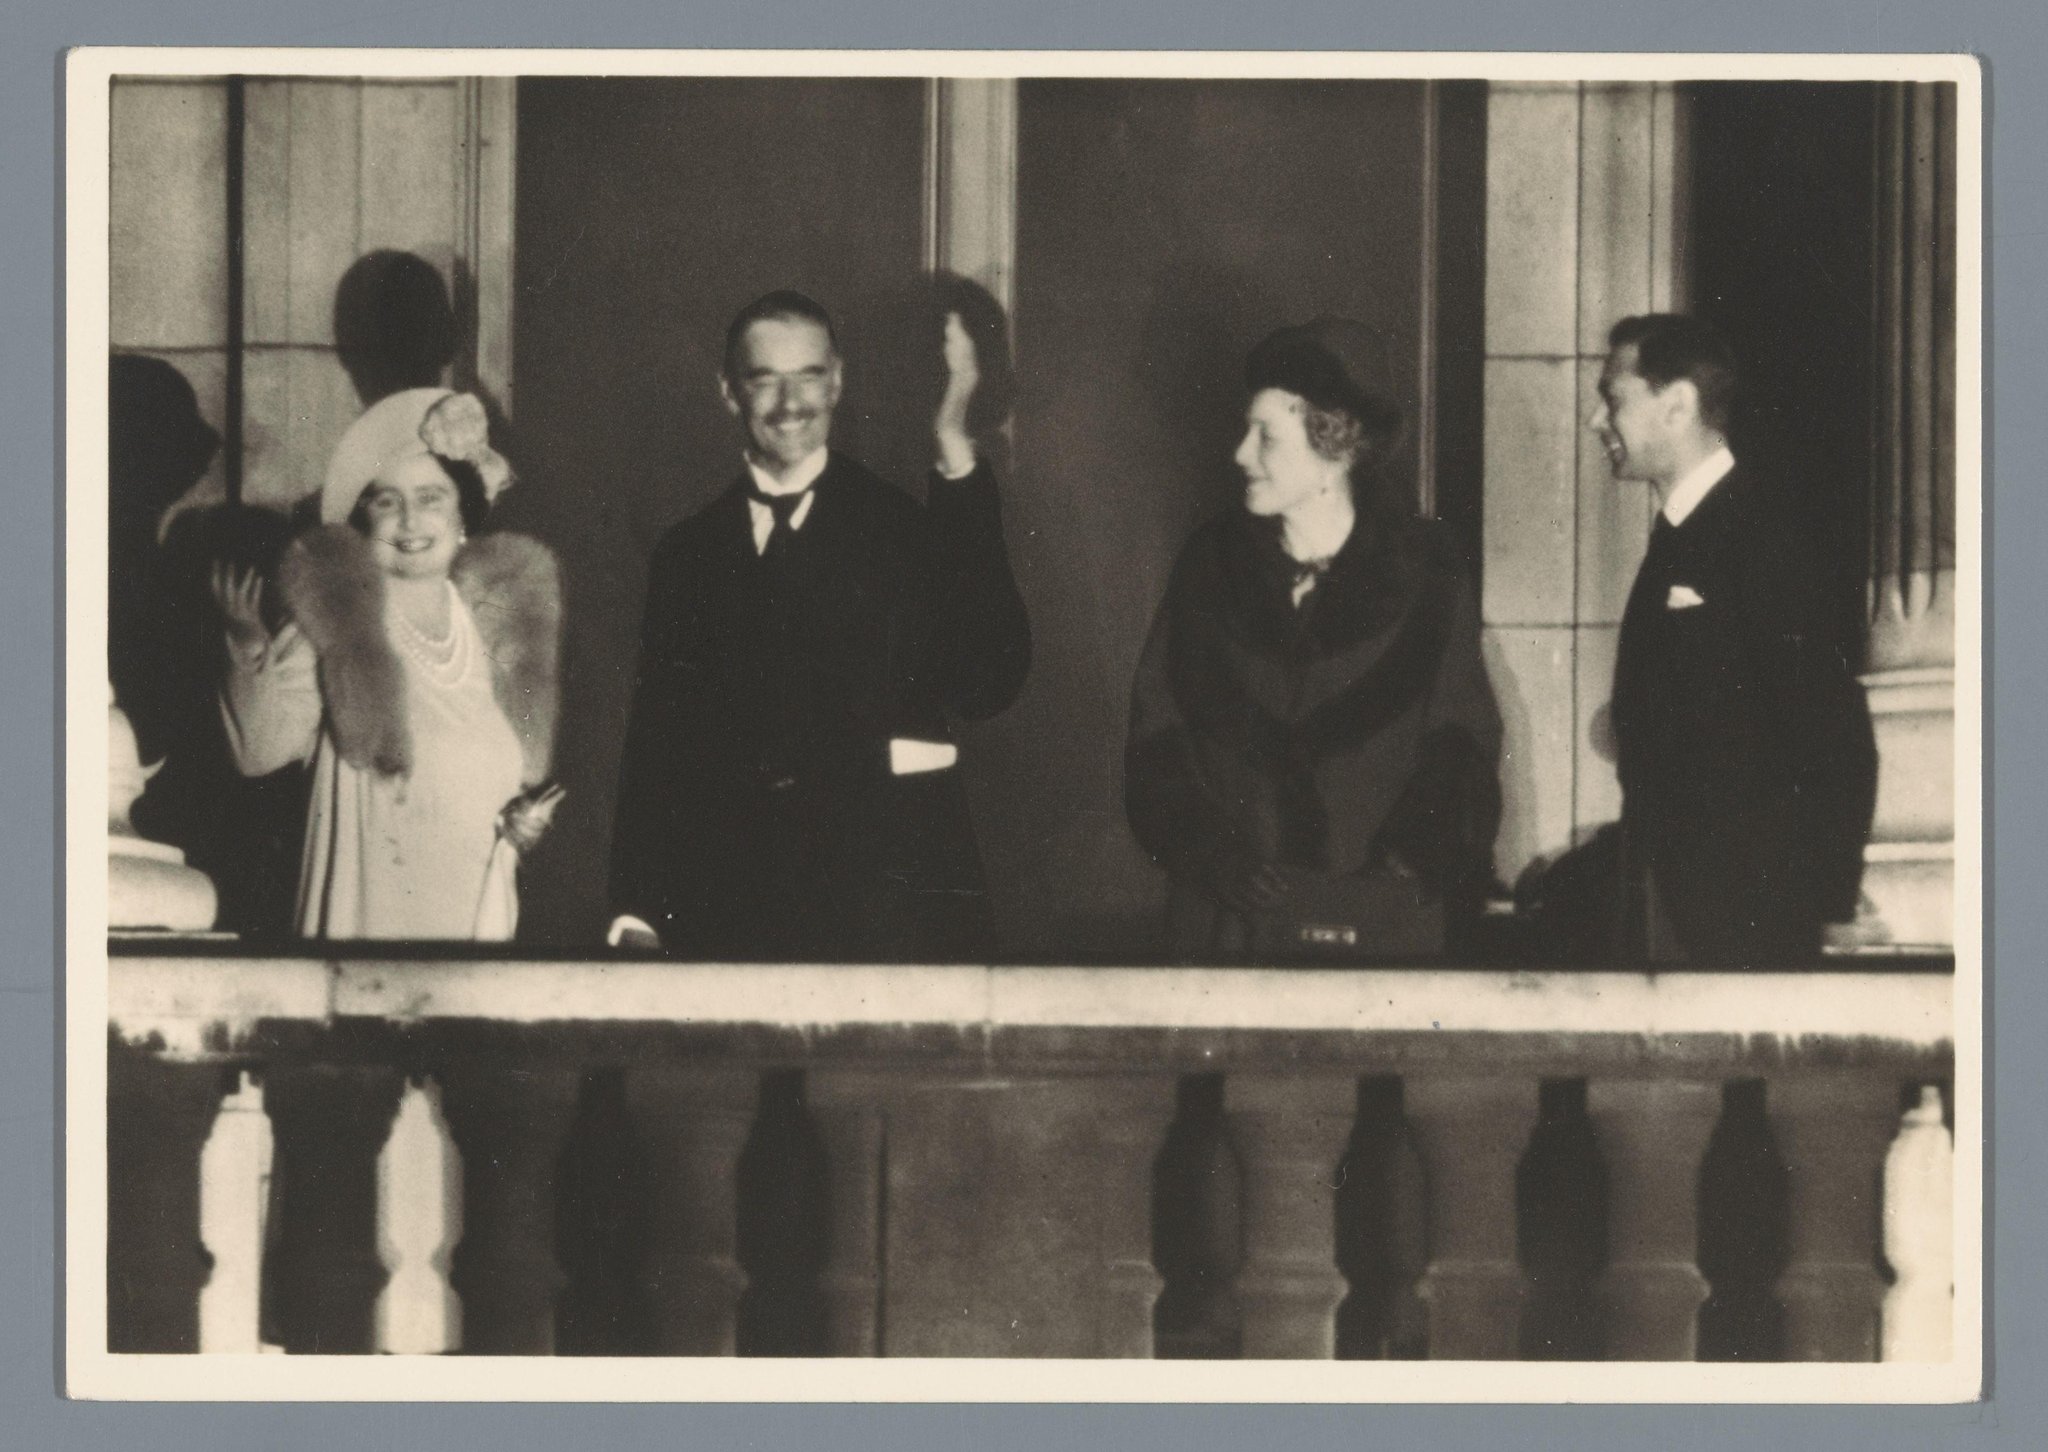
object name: photograph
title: London, 30 September 1938. Mr. en Mrs. Chamberlain, temidden van het Engelsche koningspaar op het balcon van Buckingham Palace, danken voor de enthousiaste ontvangst na terugkeer van Chamberlain van de succesvolle vredesconferentie te München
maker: Anonymous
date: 1938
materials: photographic support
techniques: gelatin silver print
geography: amsterdam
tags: london, politician, e.g. party leader, ruler, sovereign